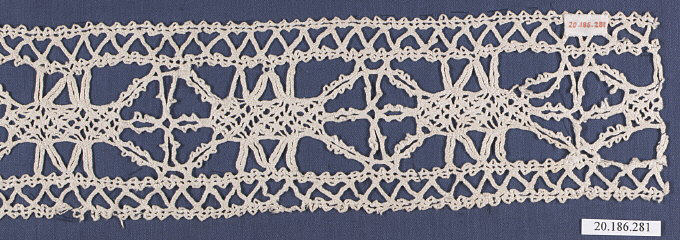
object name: insertion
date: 1501-1600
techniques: lace